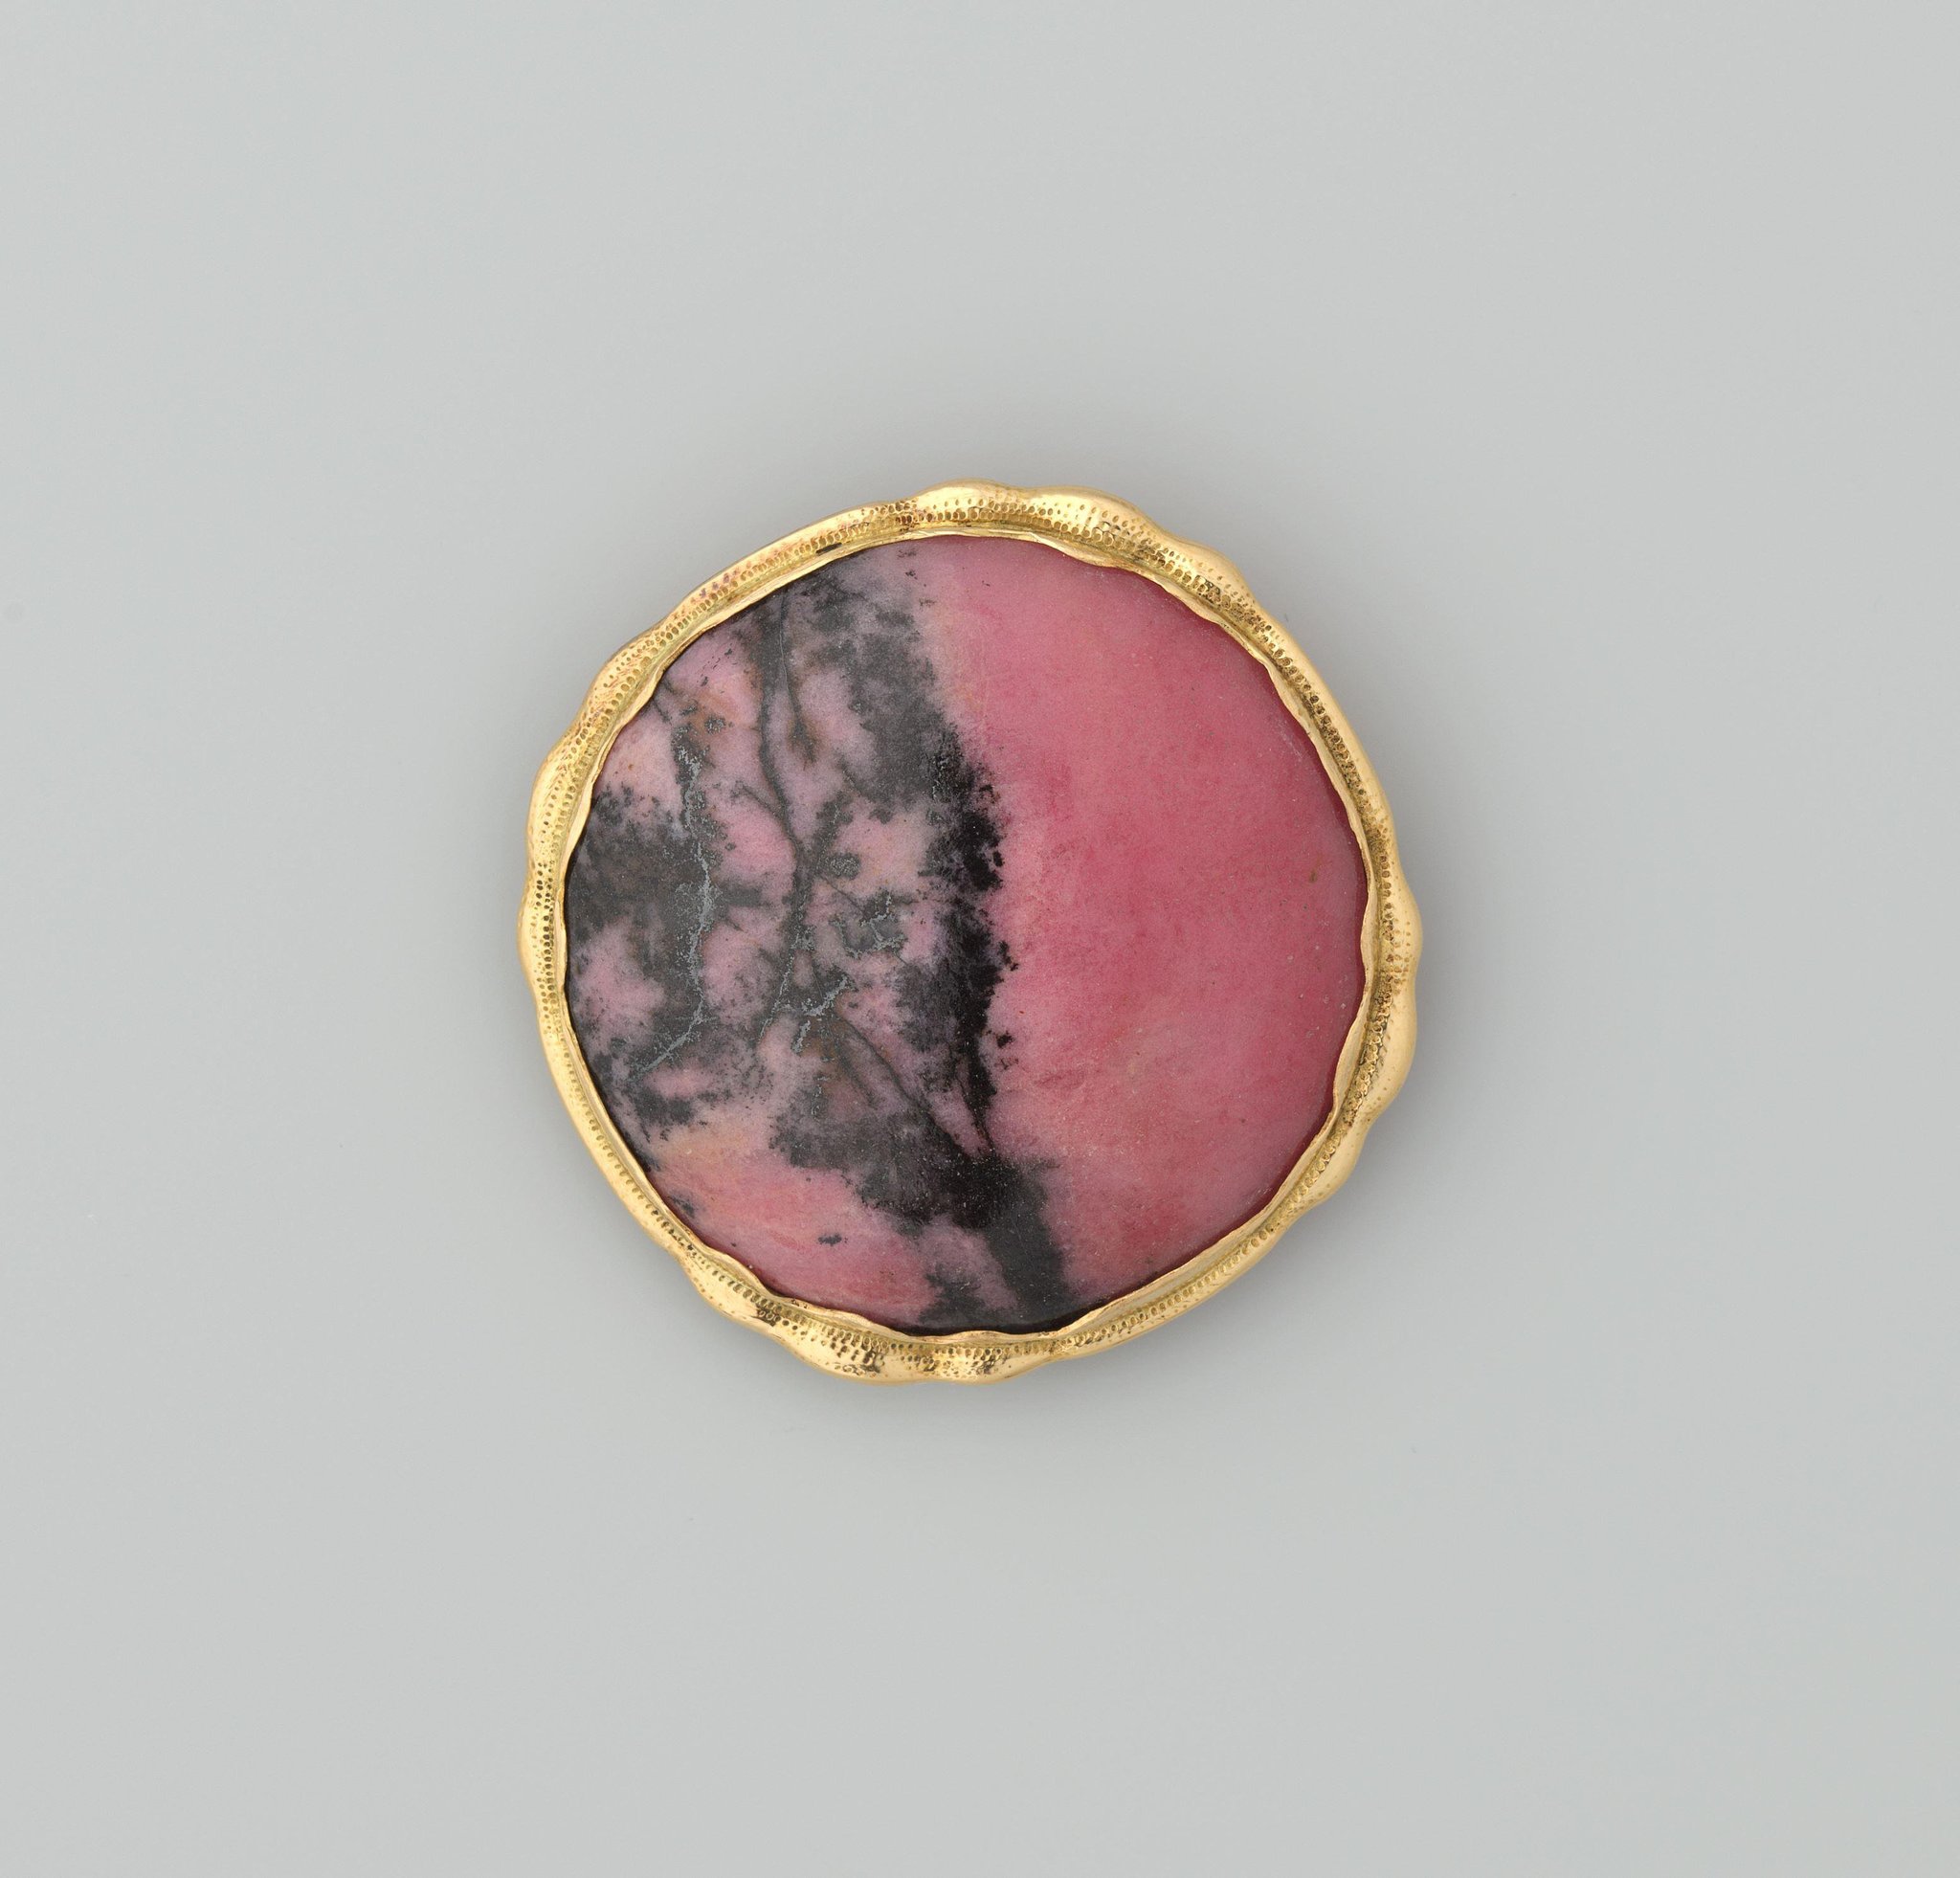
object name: brooch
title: Ronde broche met goud en rhodoniet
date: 1915-1930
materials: gold, mineral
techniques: grinding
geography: netherlands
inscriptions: : ‘750’, maker's mark: ‘F. Zwollo’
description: Ronde broche met goud en rond cabochon geslepen rhodoniet.